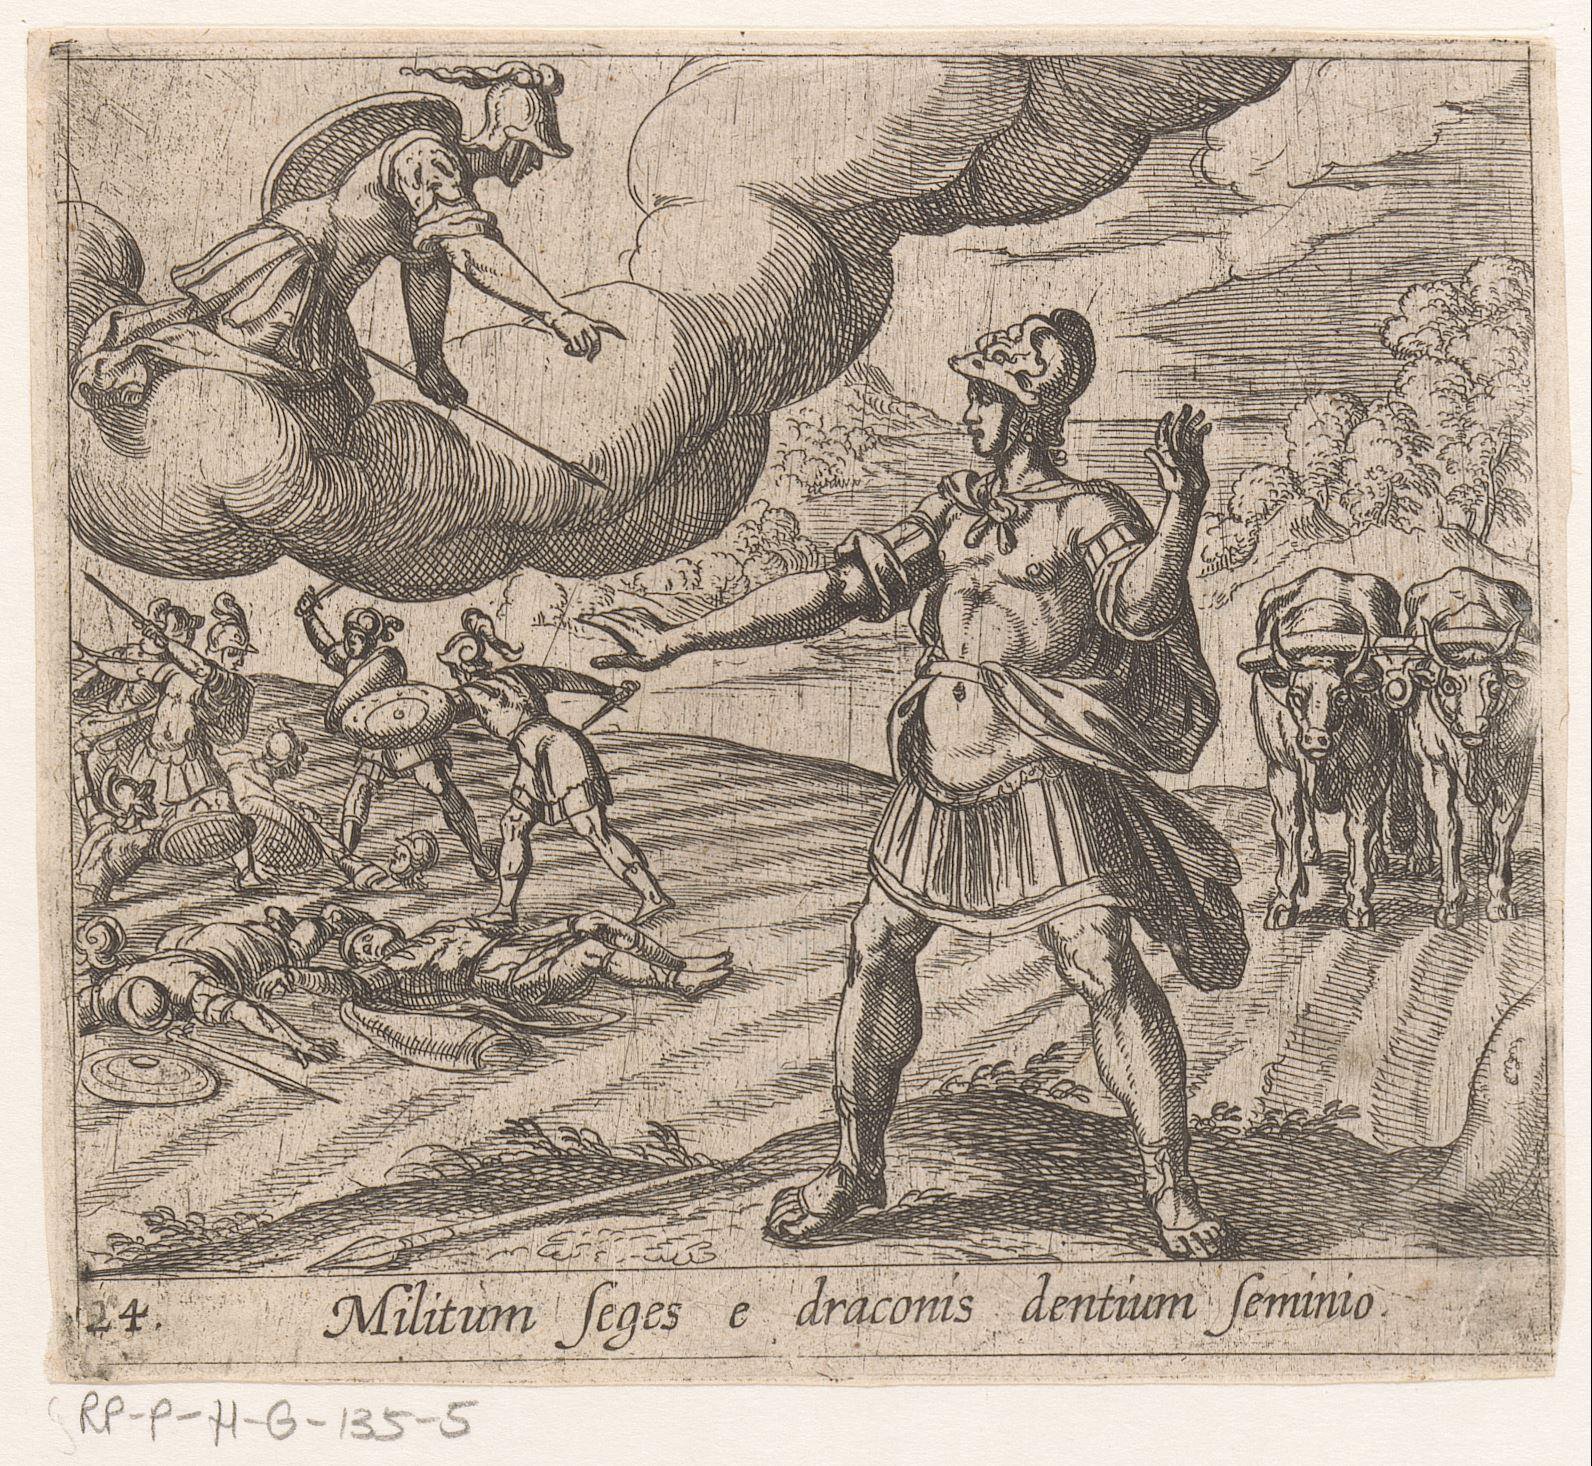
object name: print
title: Metamorfosen van Ovidius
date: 1606-1638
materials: paper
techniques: etching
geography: amsterdam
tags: after ploughing, jason sows dragon's teeth; armed men emerge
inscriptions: collector's mark: ‘Hinloopen’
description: Deze prent maakt deel uit van een reeks van 150 prenten (+ titelprent) met voorstellingen van de Metamorfosen van Ovidius.